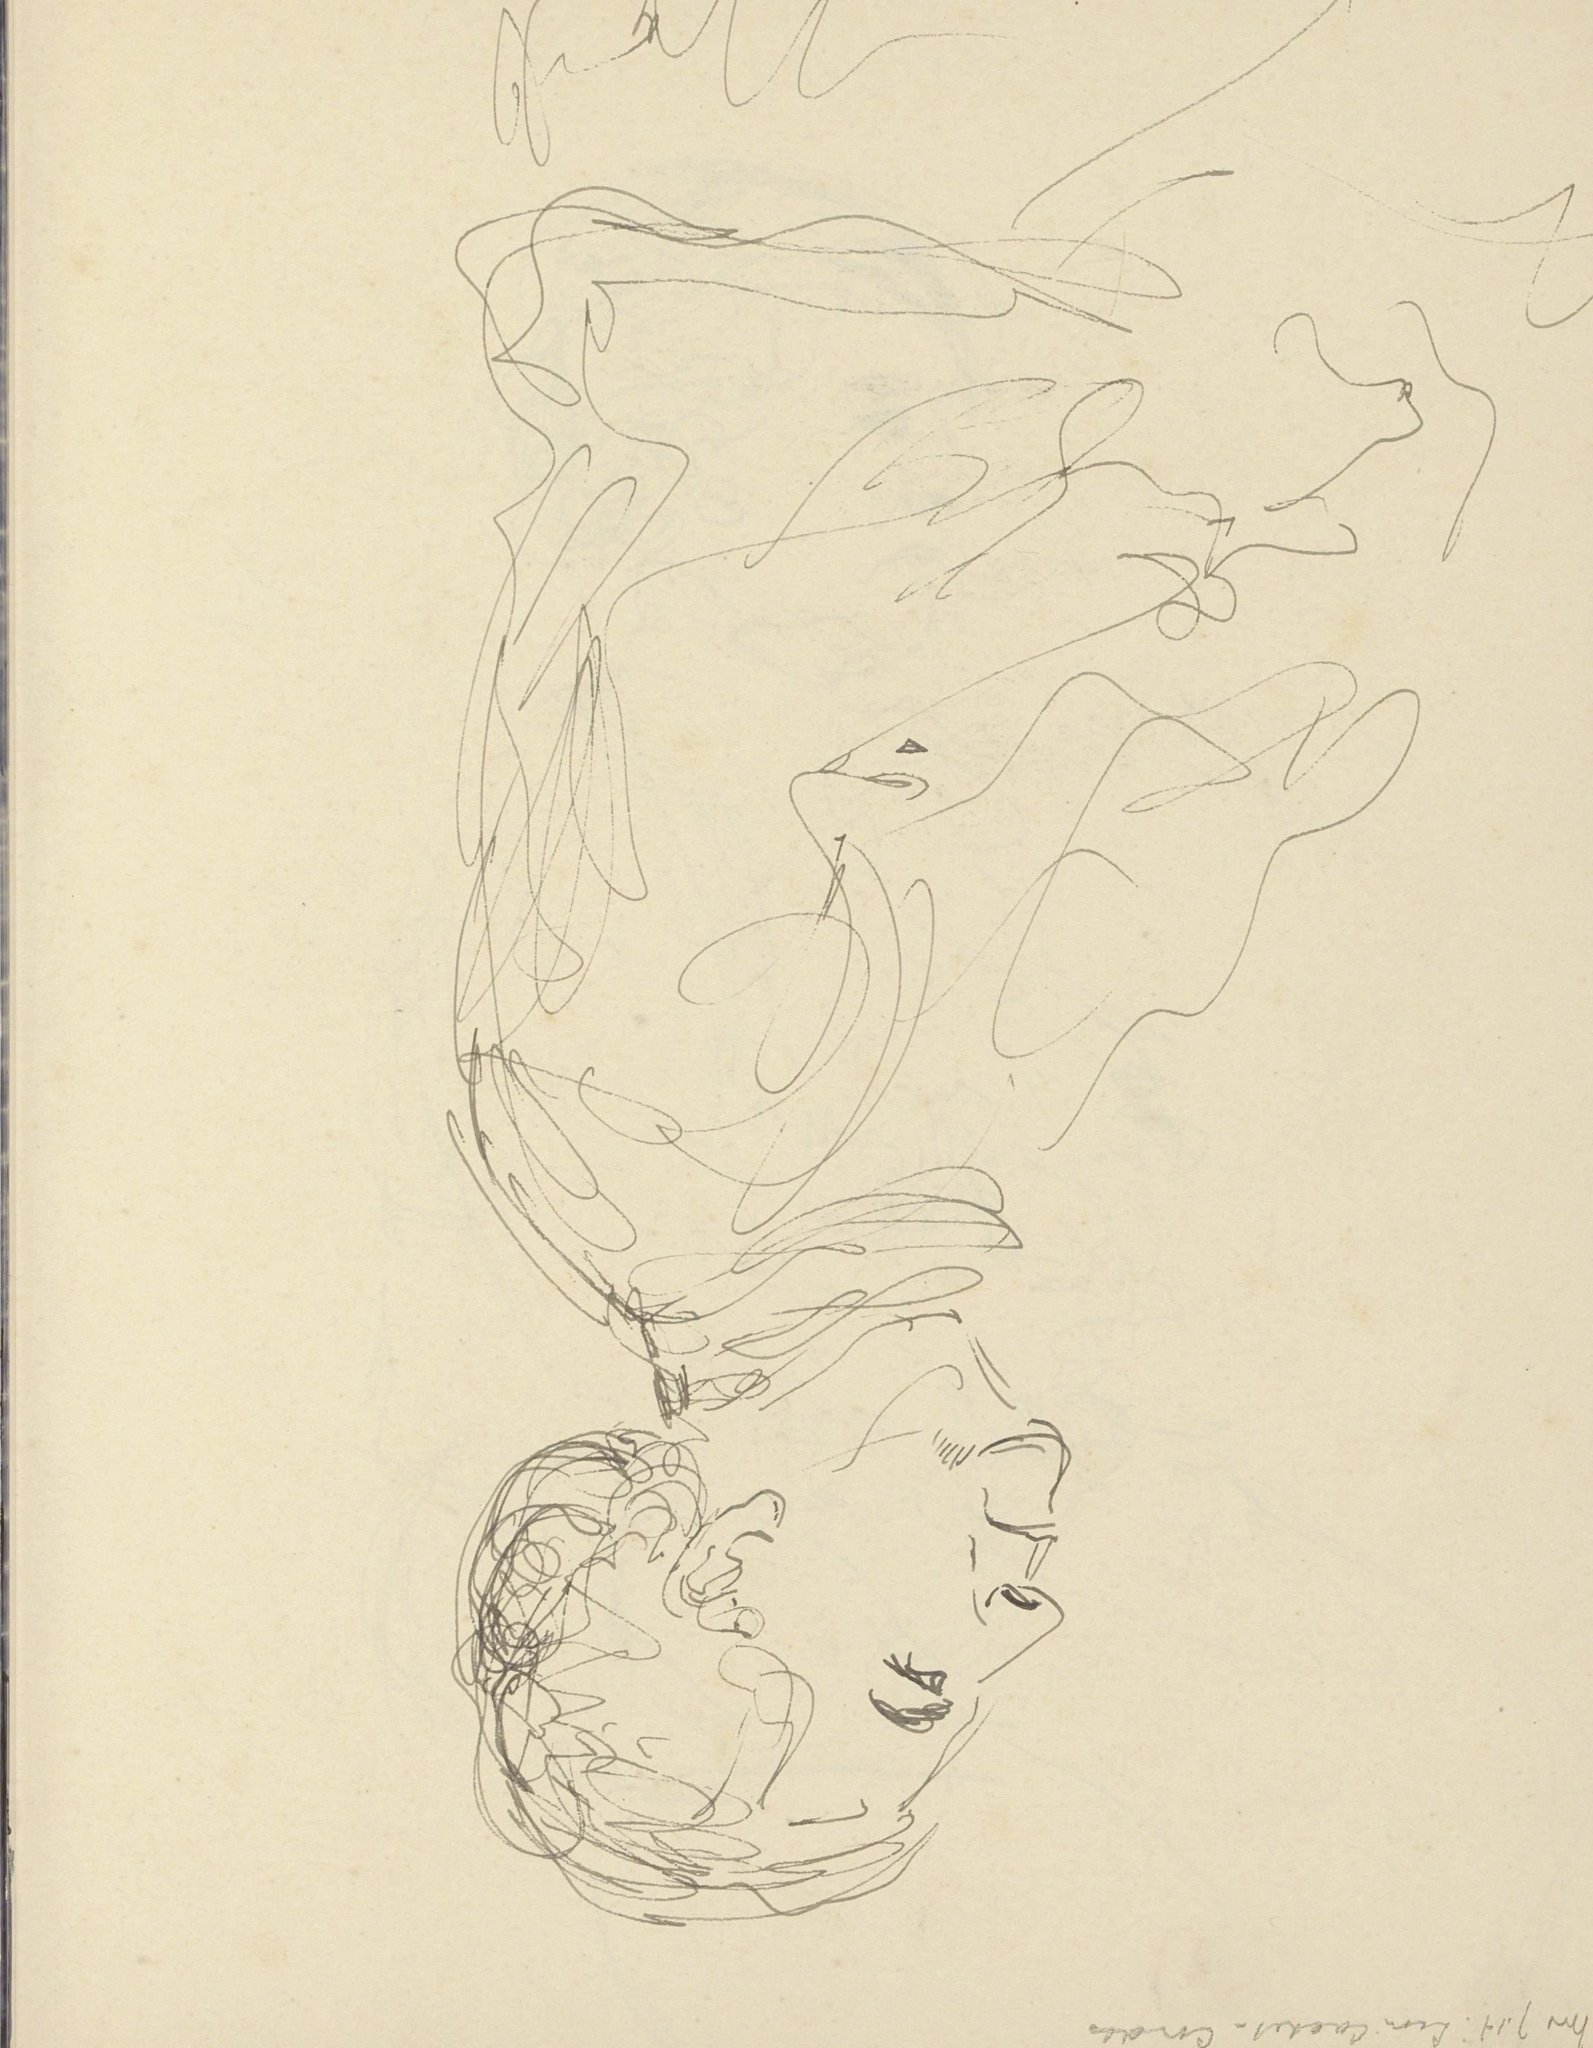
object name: sketchbook leaf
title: Portret van Joanna Hermine Lion Cachet-Cordes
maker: carel adolph lion cachet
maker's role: draughtsman, print maker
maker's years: 1864-1945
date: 1930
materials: ink, paper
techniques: pen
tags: adult woman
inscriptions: annotation: ‘Mw J.H. Lion Cachet-Cordes’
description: Blad 5 recto uit een schetsboek met 9 bladen.